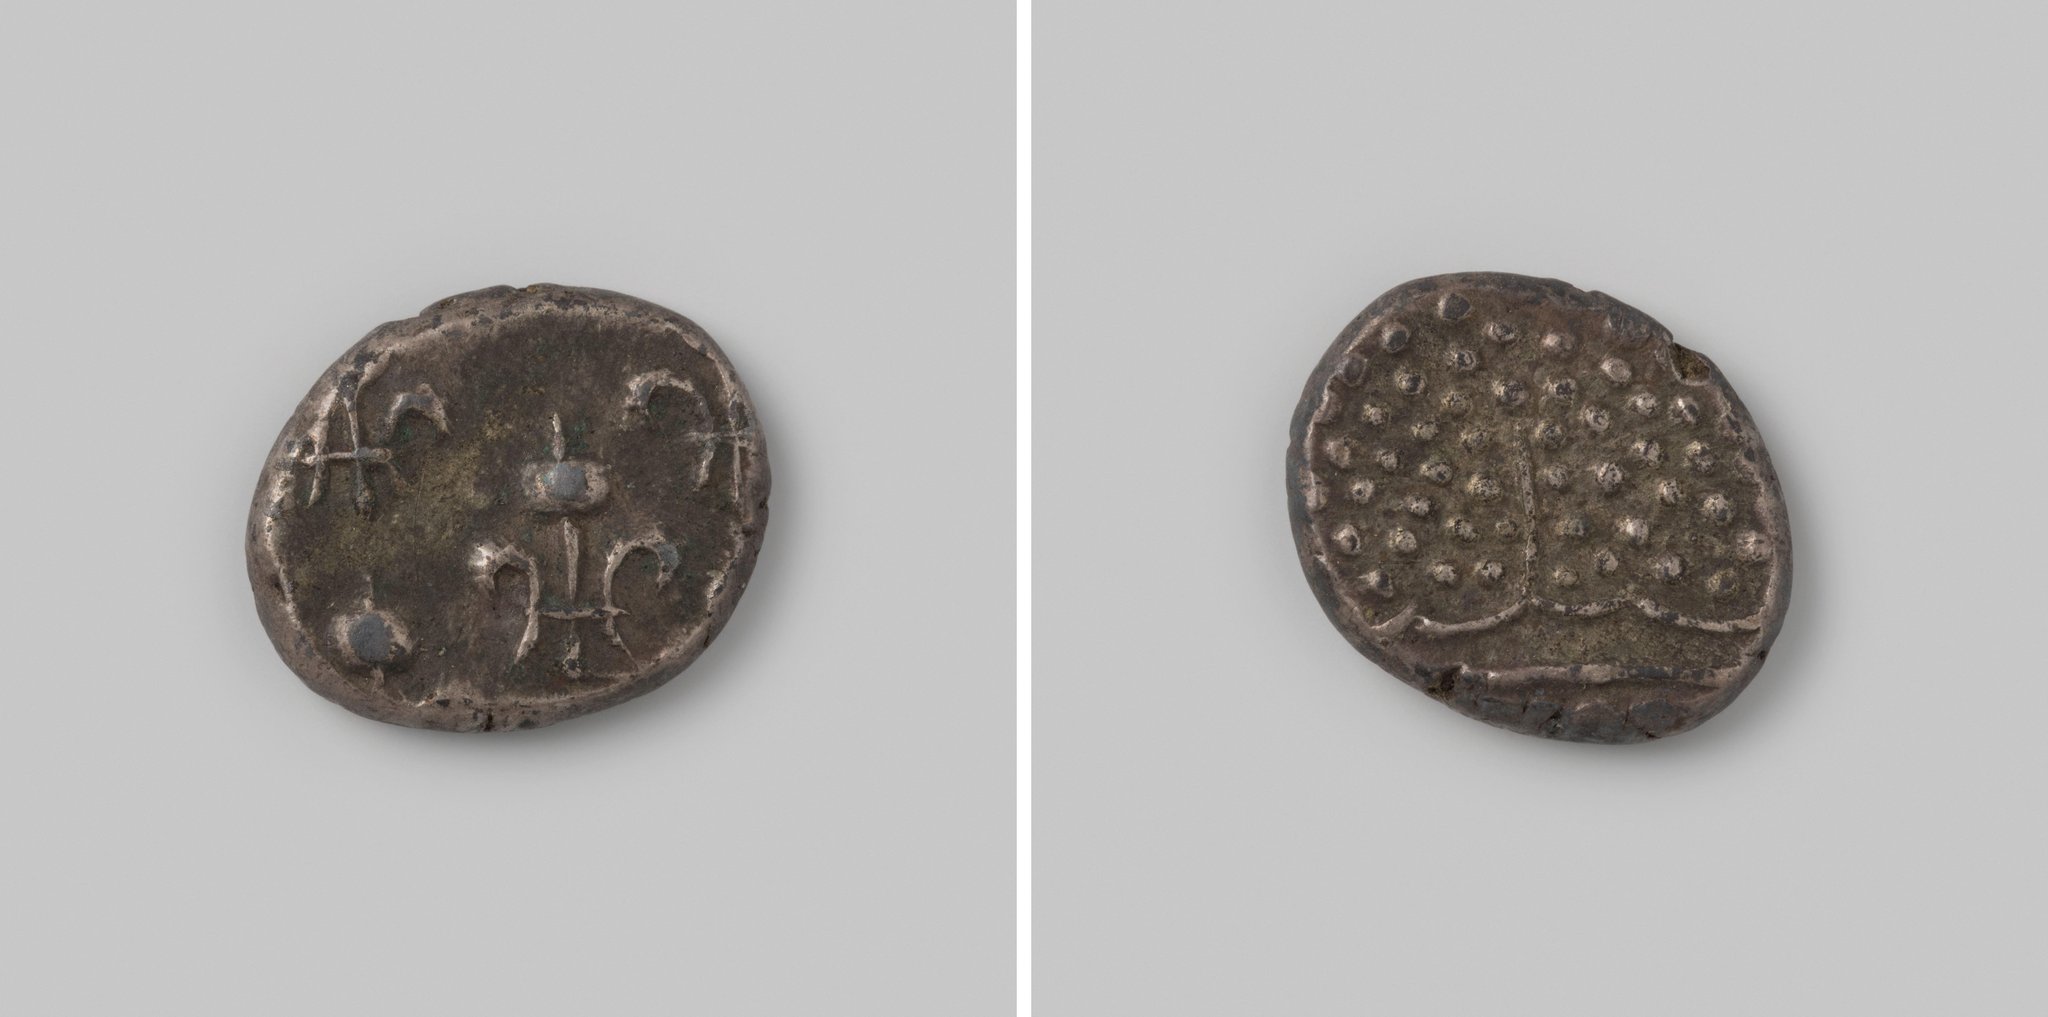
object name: coin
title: 2 royalins of fanam uit Pondicherry in India van de Franse Compagnie perpétuelle des Indes,1720-1837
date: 1720-1837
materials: silver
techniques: striking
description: Zilveren munt. Voorzijde: kroon, voorzien van stippen, parels. Keerzijde: in drie rijen vijf lelies. Gladde rand.